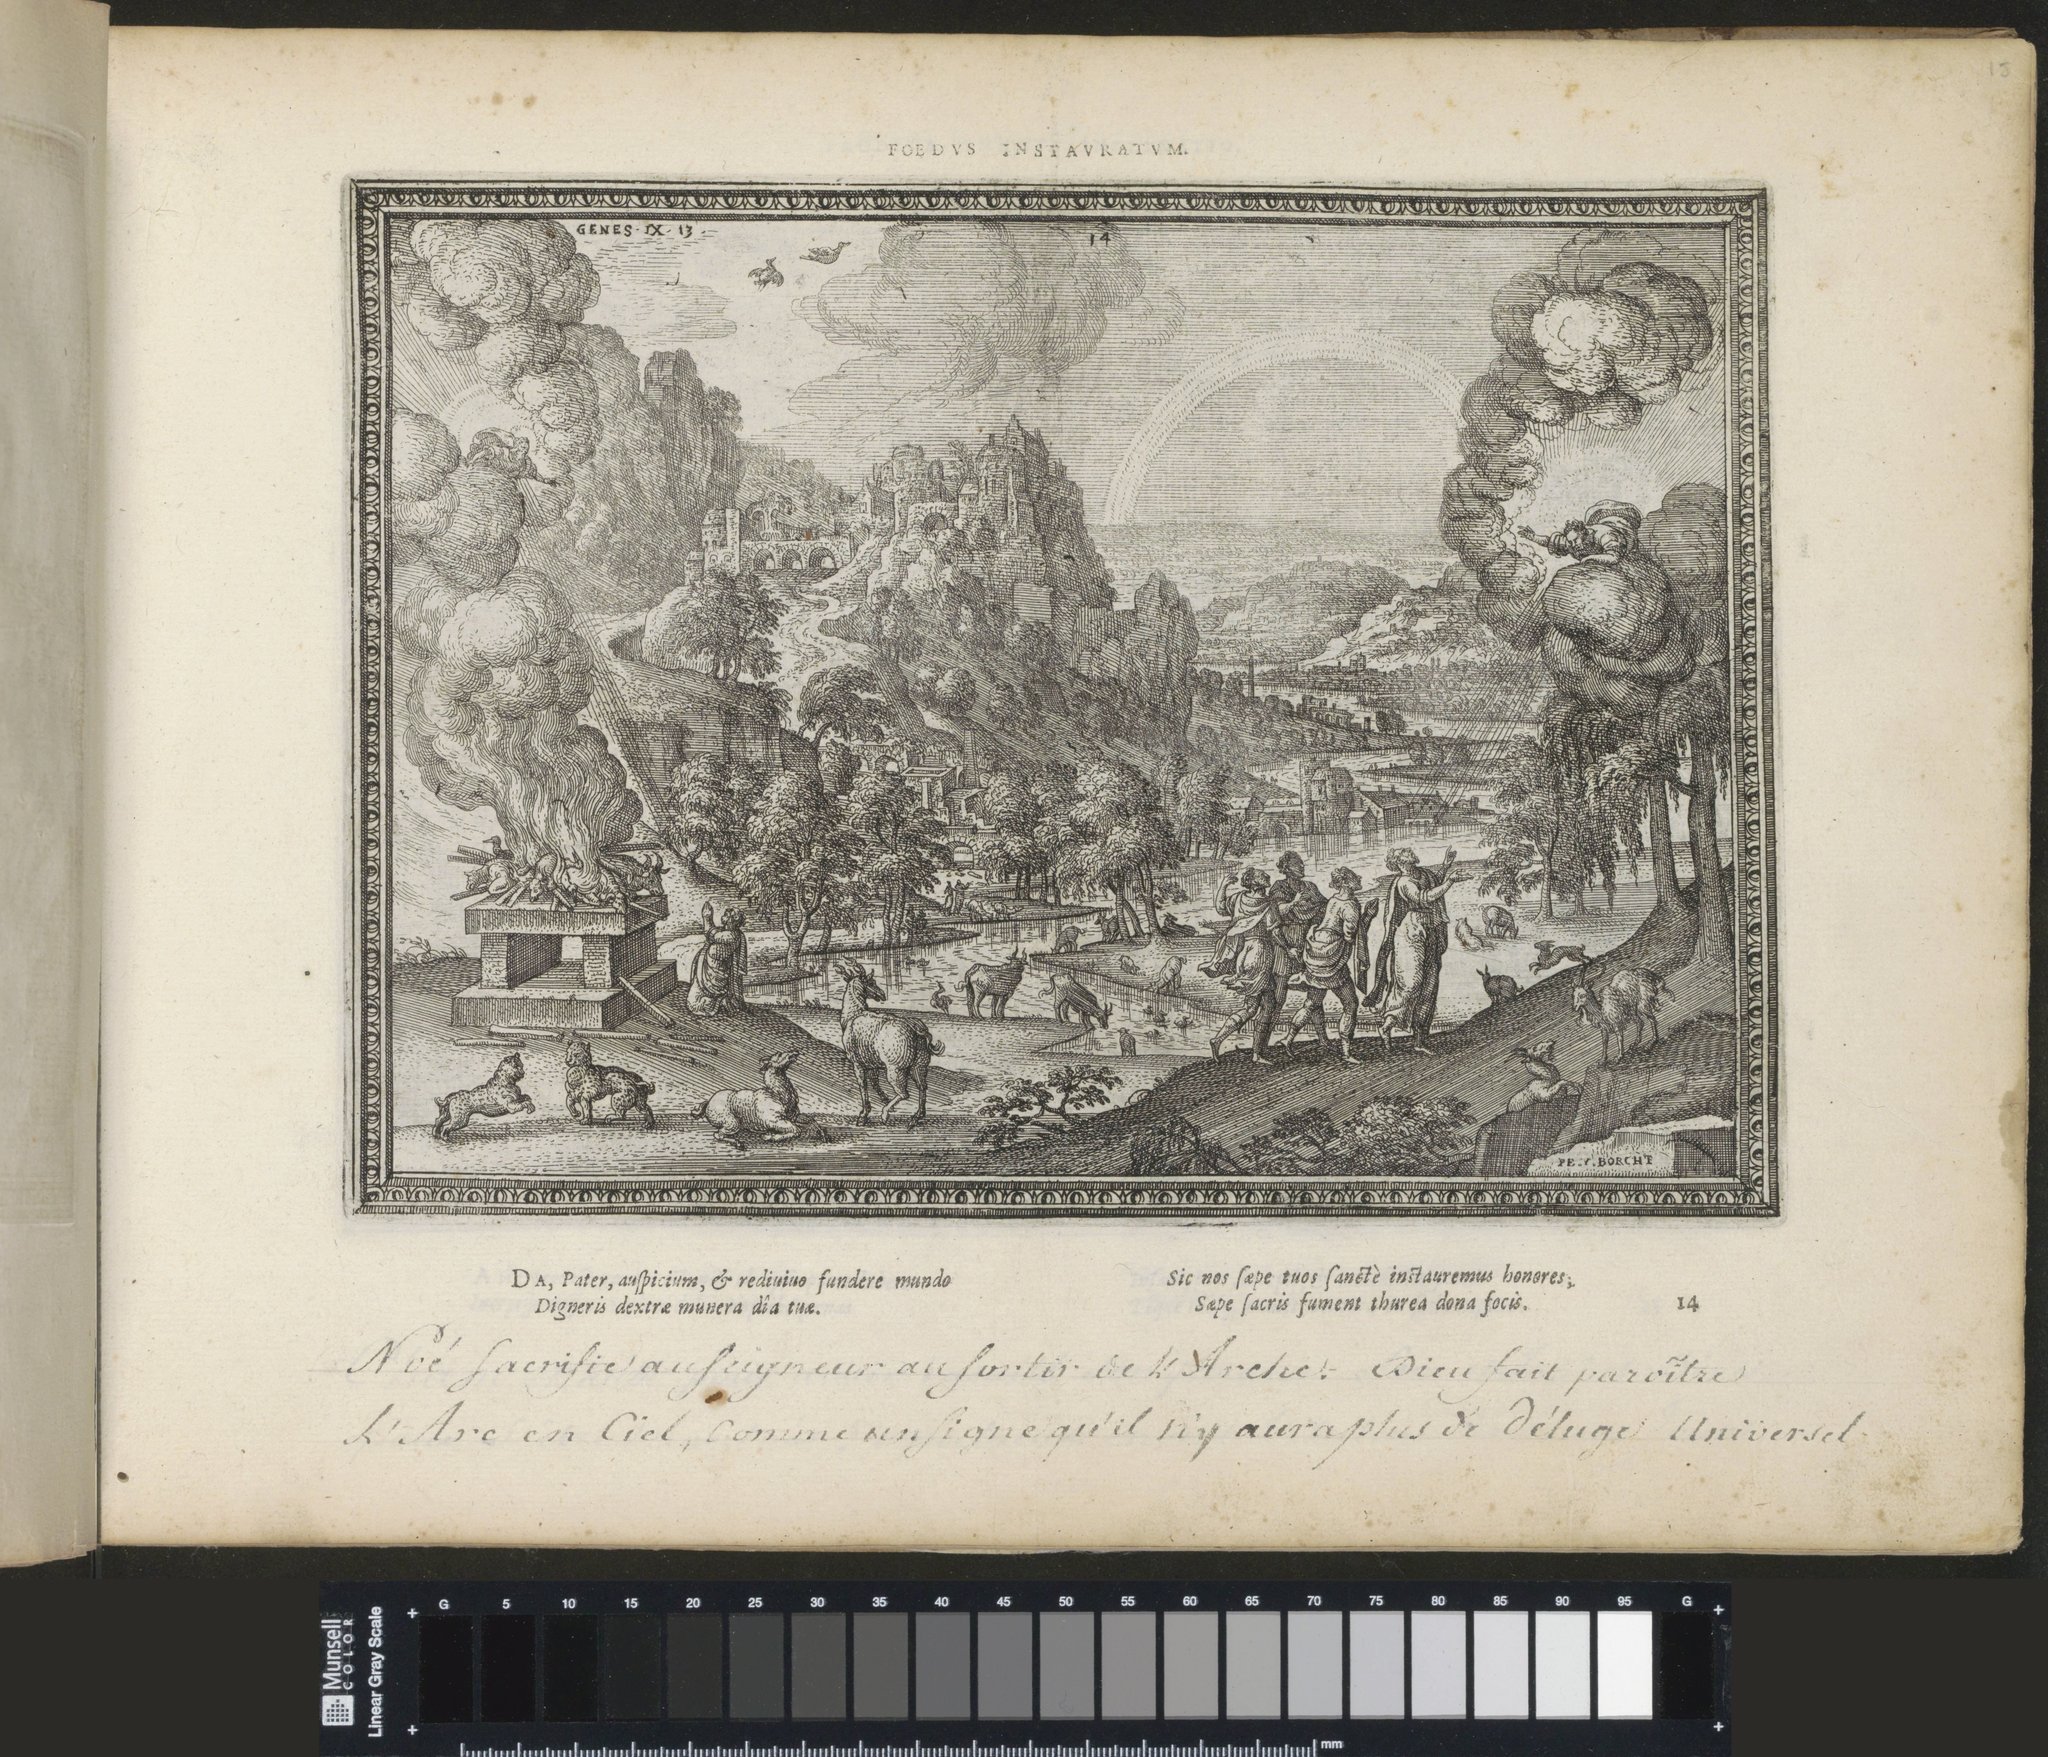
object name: album leaf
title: Imagines et figurae bibliorum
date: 1582-1593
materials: paper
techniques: etching, letterpress printing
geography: antwerp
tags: noah's sacrifice; various animals are offered, possibly a lamb, a dove and a ram (often combined with the rainbow of the covenant)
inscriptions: inscription: ‘Noé sacrifie au seigneur au sortir de l'Arche. Dieu fait pareitre l'Arc en Ciel, Comme un signe qu'il aura plus de déluge Universel’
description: Links knielt Noach bij een offeraltaar. Daarop liggen verschillende dieren. Op de achtergrond de regenboog die God toont als teken van zijn belofte om de aarde nooit meer met een zondvloed te vernietigen (Gen. 9:13). Met een motto in het Latijn boven de voorstelling en een vierregelig onderschrift in het Latijn onder de prent. De prent maakt deel uit van een album.